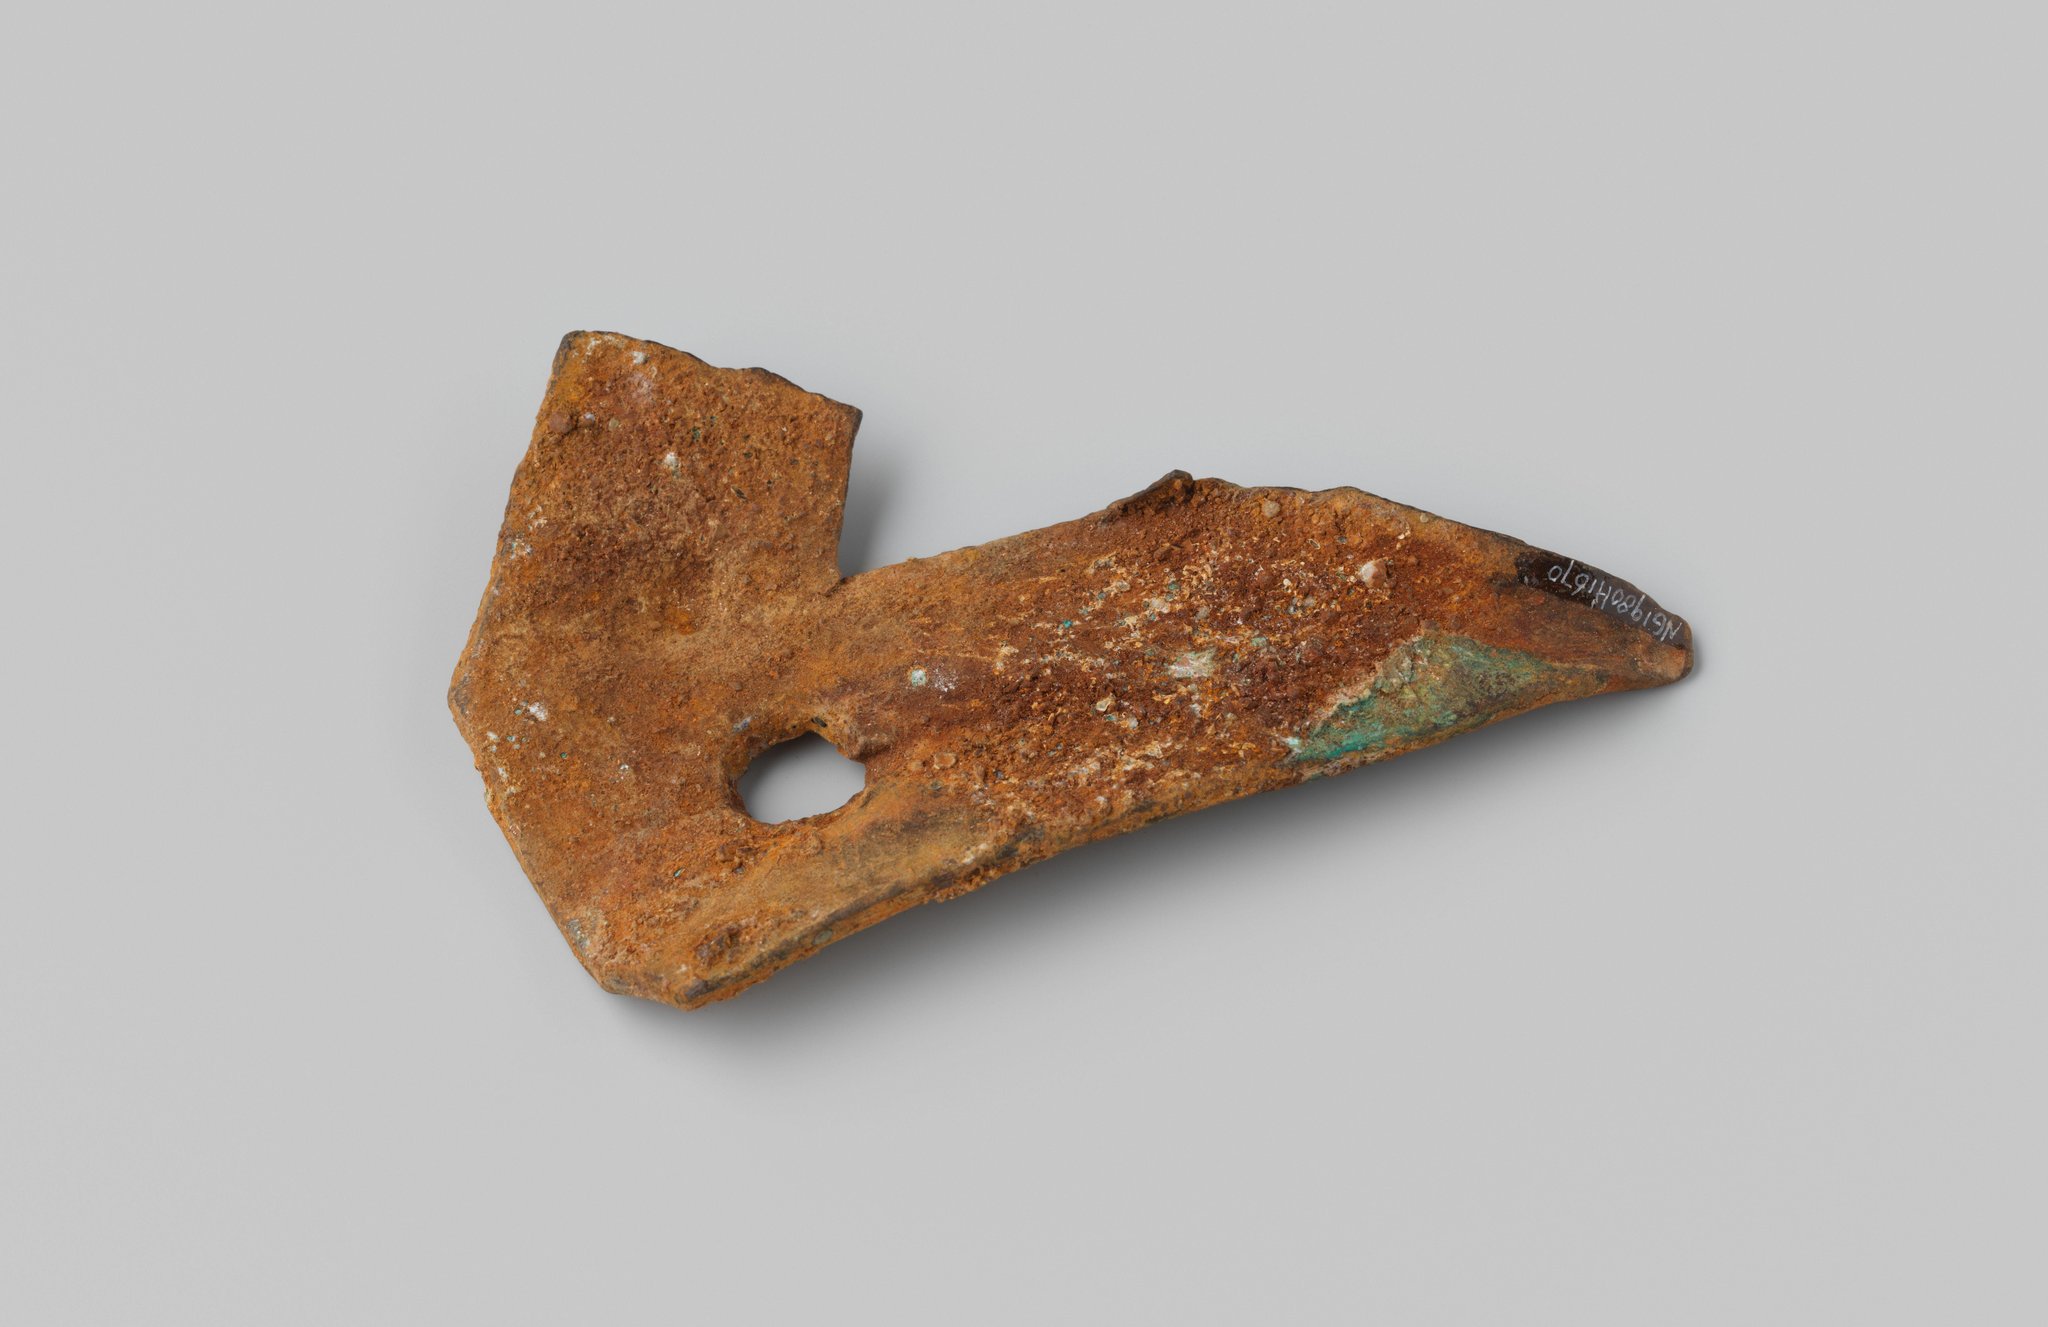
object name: part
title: Onderdeel of hulpstuk afkomstig uit het wrak van de Oost-Indiëvaarder Hollandia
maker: Anonymous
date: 1700-1743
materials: copper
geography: netherlands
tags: verenigde oostindische compagnie, hollandia (schip)